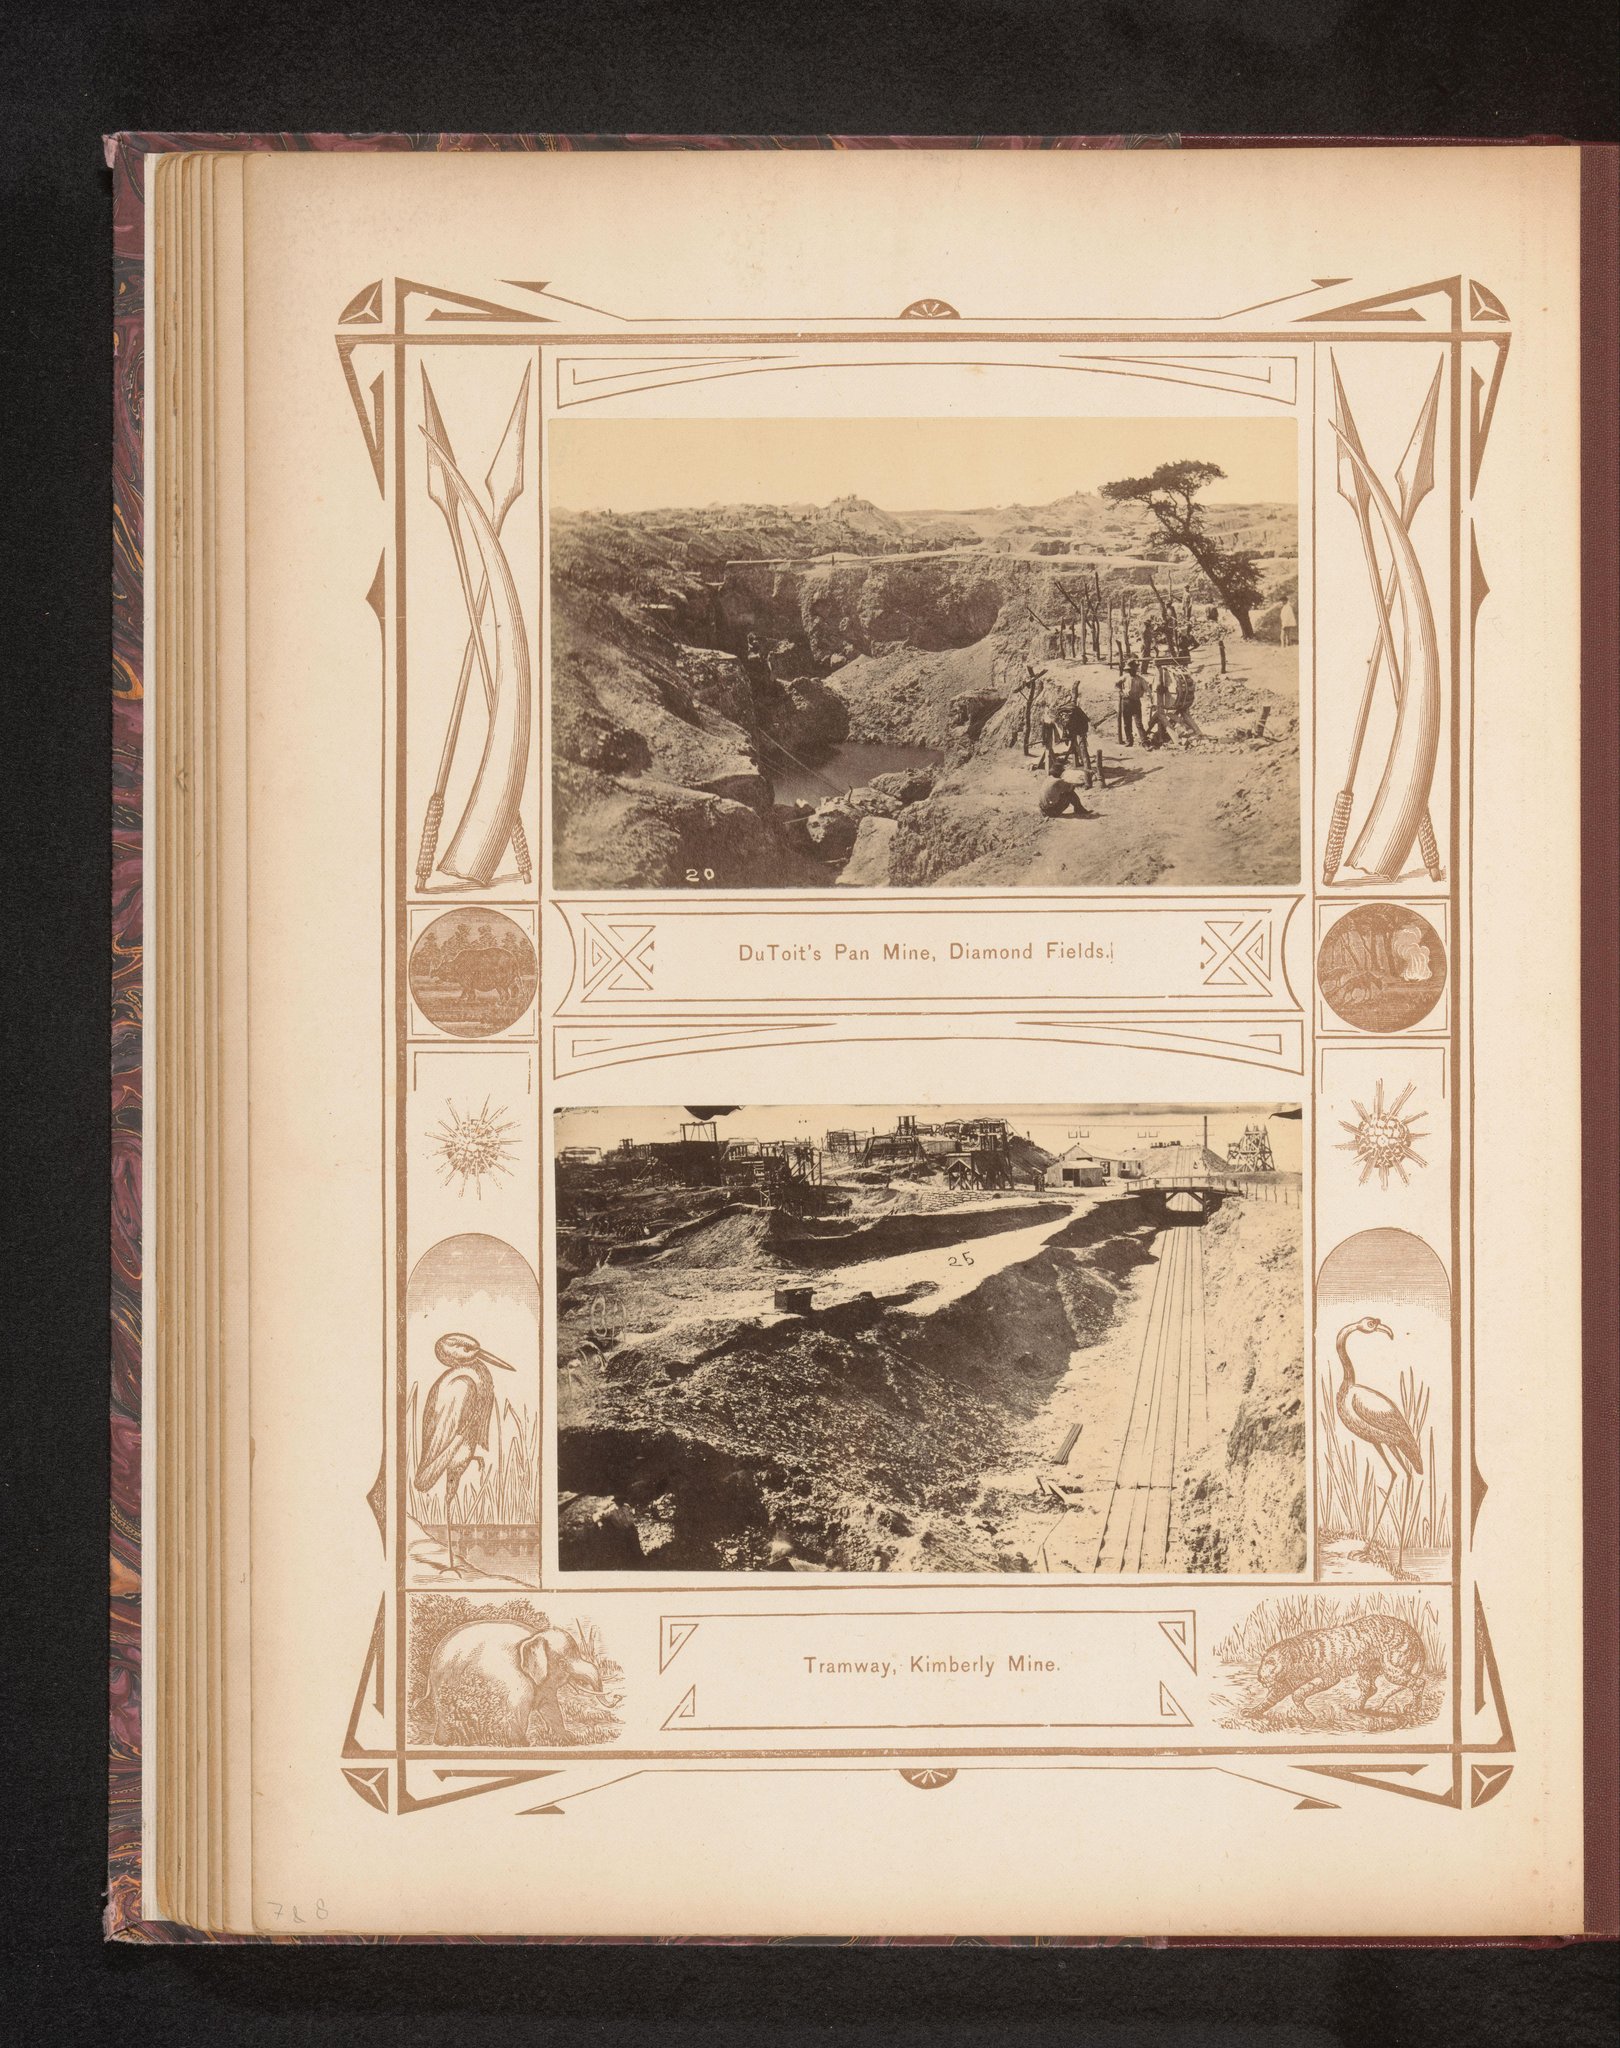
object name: page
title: Gezicht op rails bij de Kimberly mijn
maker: Anonymous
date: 1877-1882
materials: photographic support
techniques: albumen print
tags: tramway, tram, mine